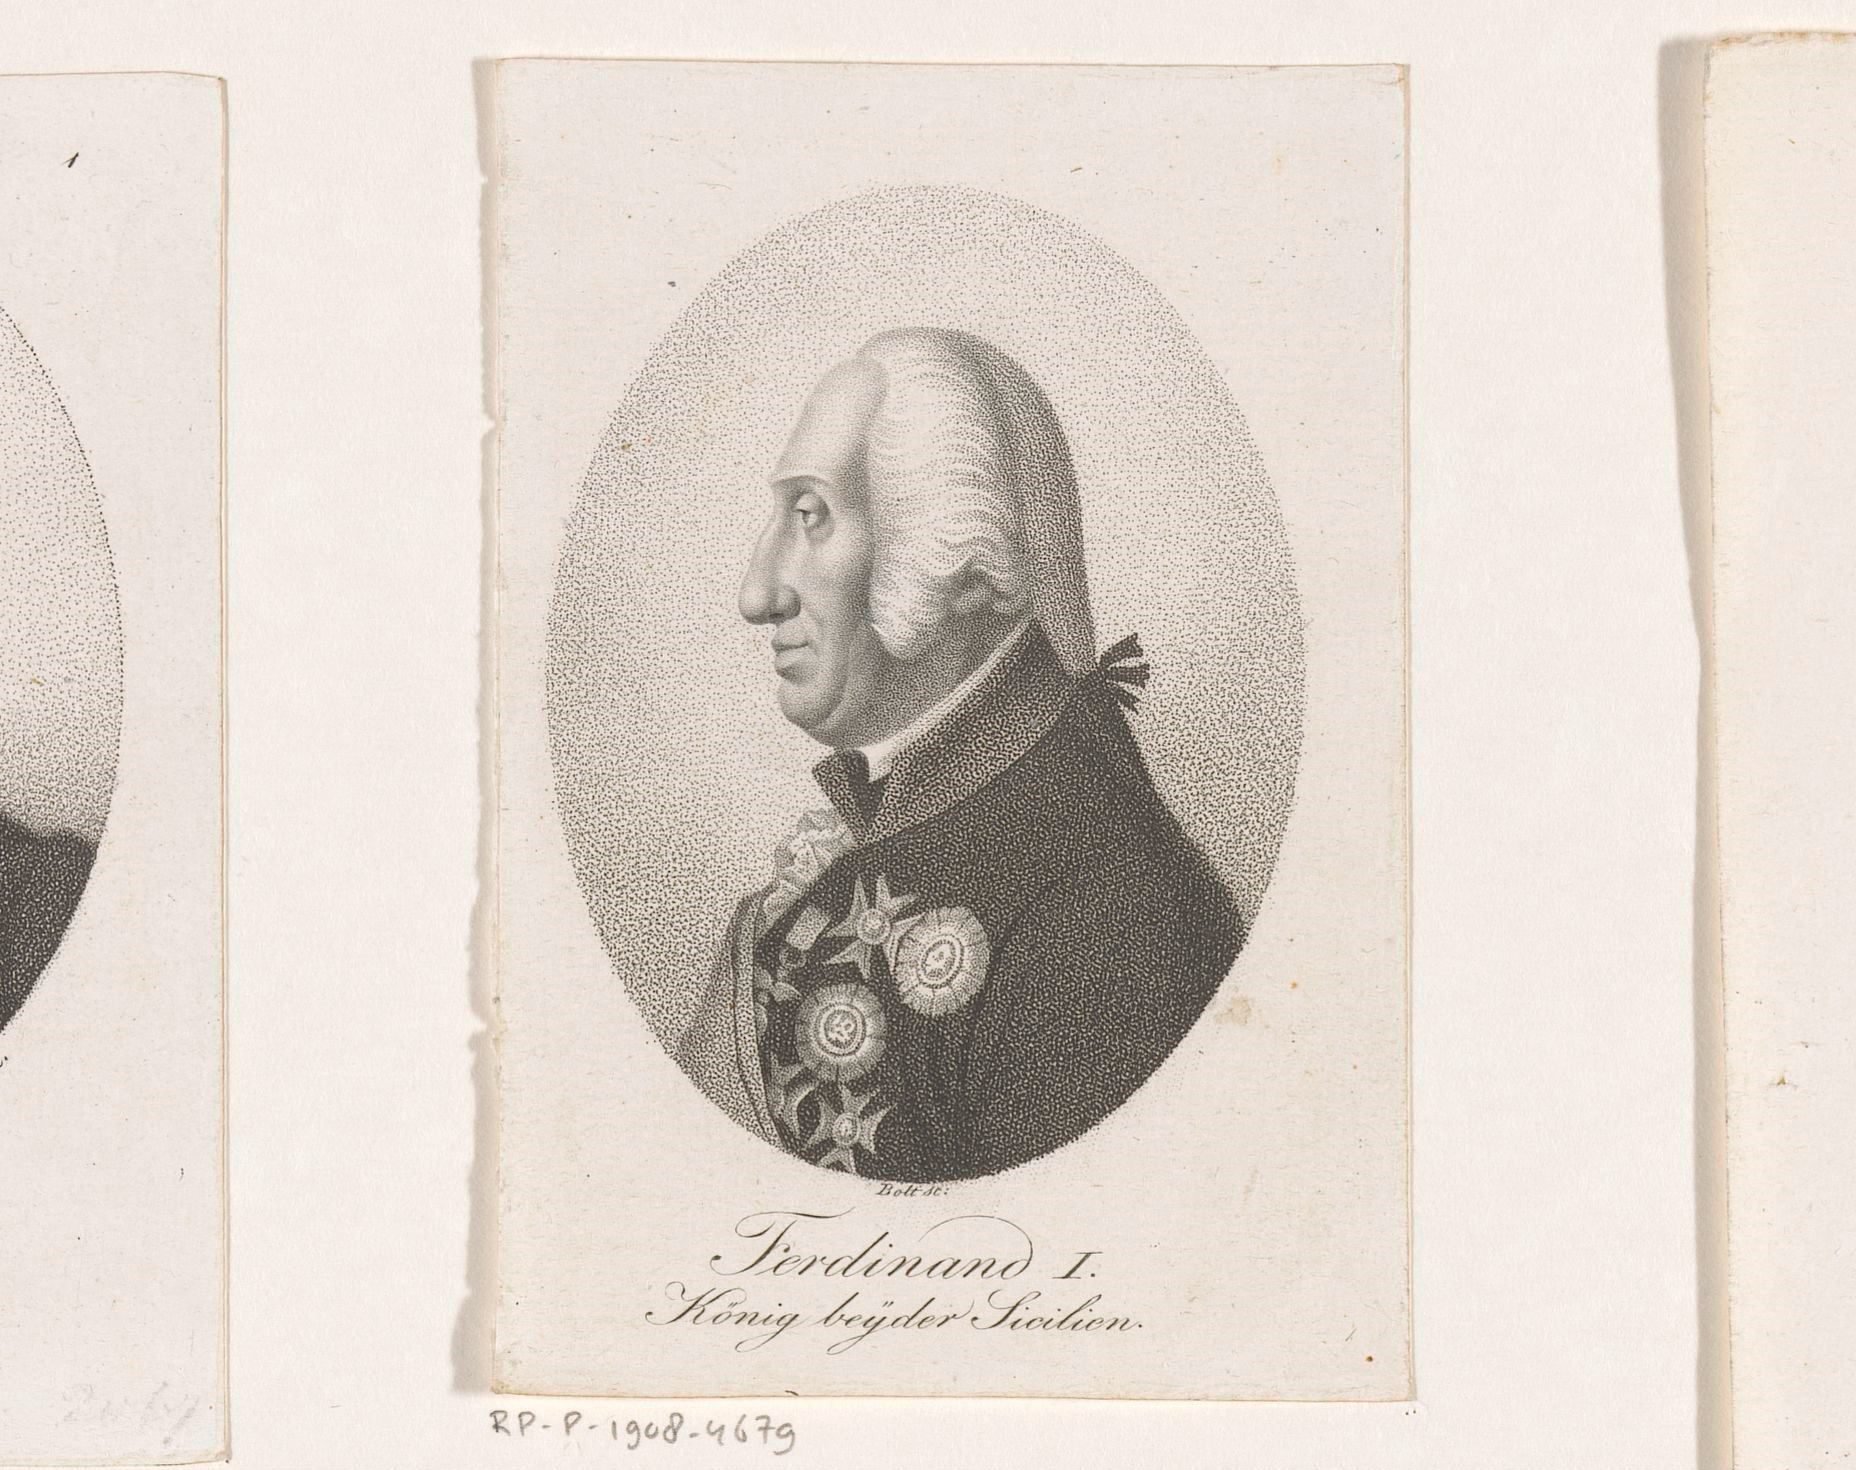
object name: print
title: Portret van Ferdinand I, koning der beide Siciliën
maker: johann friedrich bolt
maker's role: print maker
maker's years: 1769-1836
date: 1816-1825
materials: paper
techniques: stippling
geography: berlin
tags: naples, ferdinand i (koning der beide siciliën), knighthood order, historical persons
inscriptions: collector's mark: Lugt 2228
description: Vermoedelijk afkomstig uit: Almanach de Gotha.